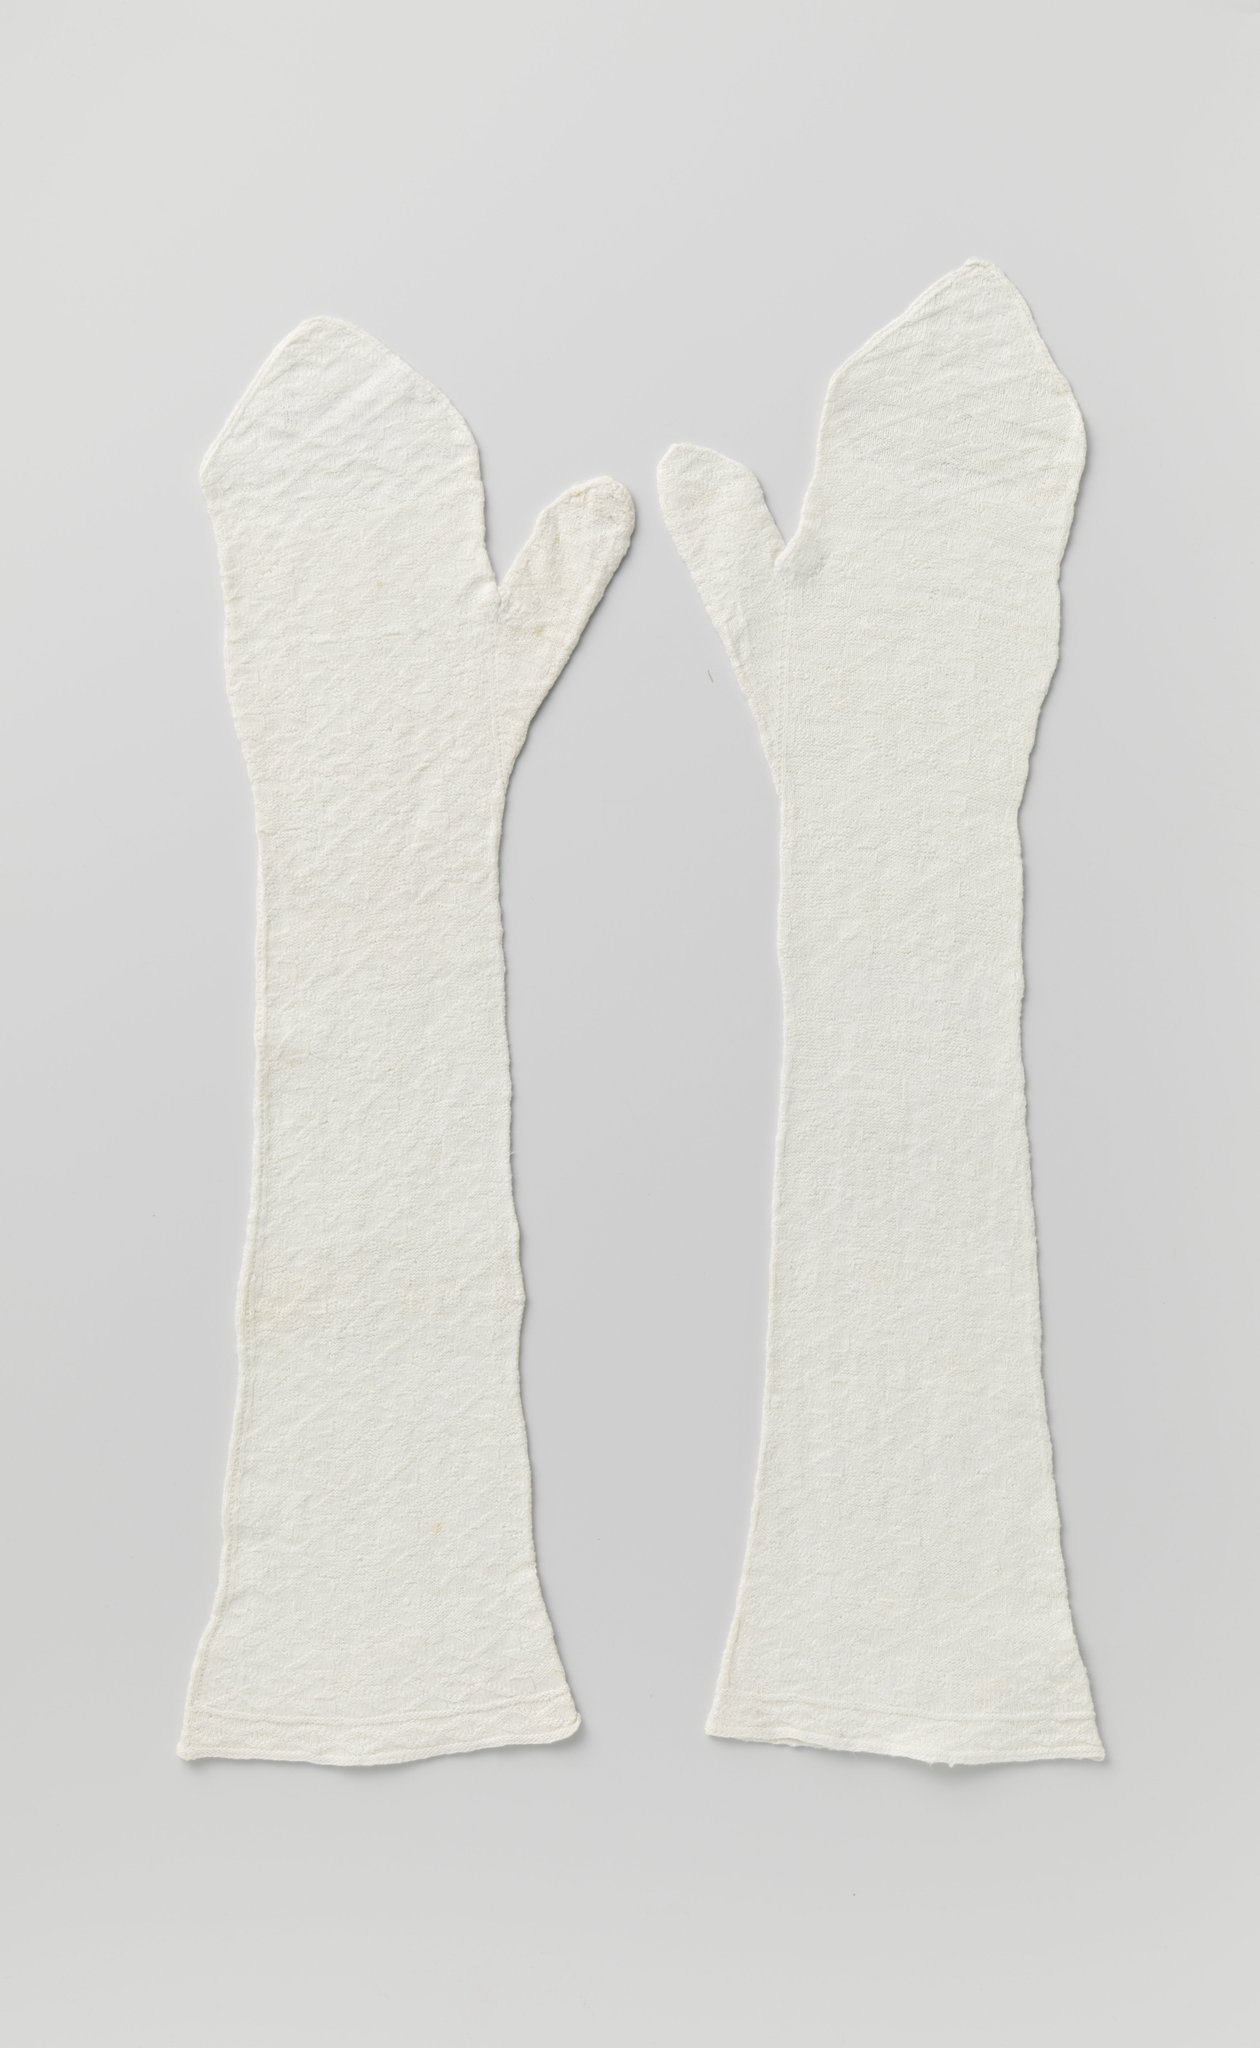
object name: clothing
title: Mitaine van witte gebreide katoen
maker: Anonymous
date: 1750-1820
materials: cotton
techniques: knitting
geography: western europe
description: Paar mitaines van gebreide katoen met een open duim. Patroon als kruiswerkdamast met doorsnijdende ruiten met ster.